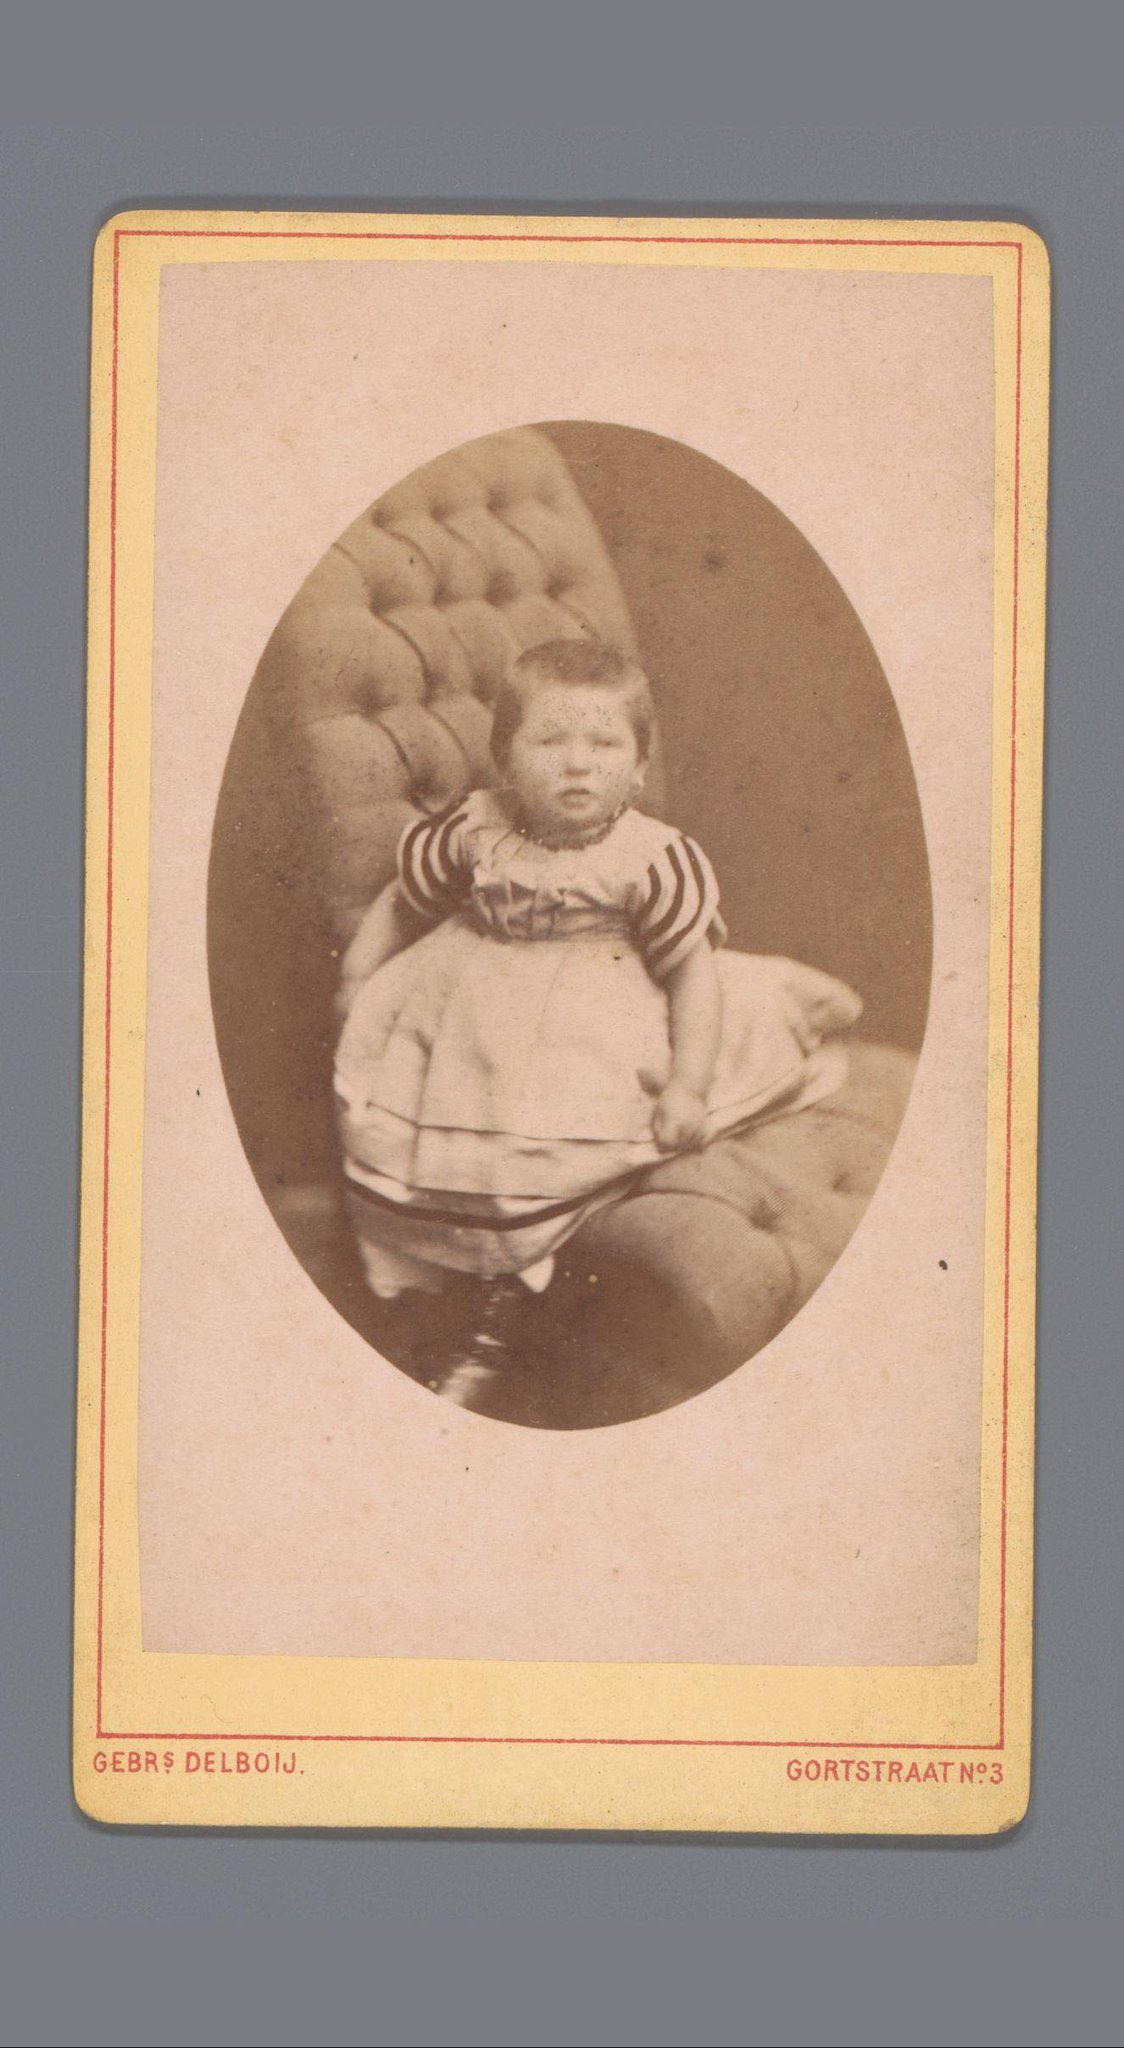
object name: carte de visite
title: Portret van een onbekend kind op een fauteuil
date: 1864-1880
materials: cardboard, paper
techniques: albumen print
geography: the hague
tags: toddler, anonymous historical person portrayed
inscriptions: address: ‘GORTSTRAAT No 3’